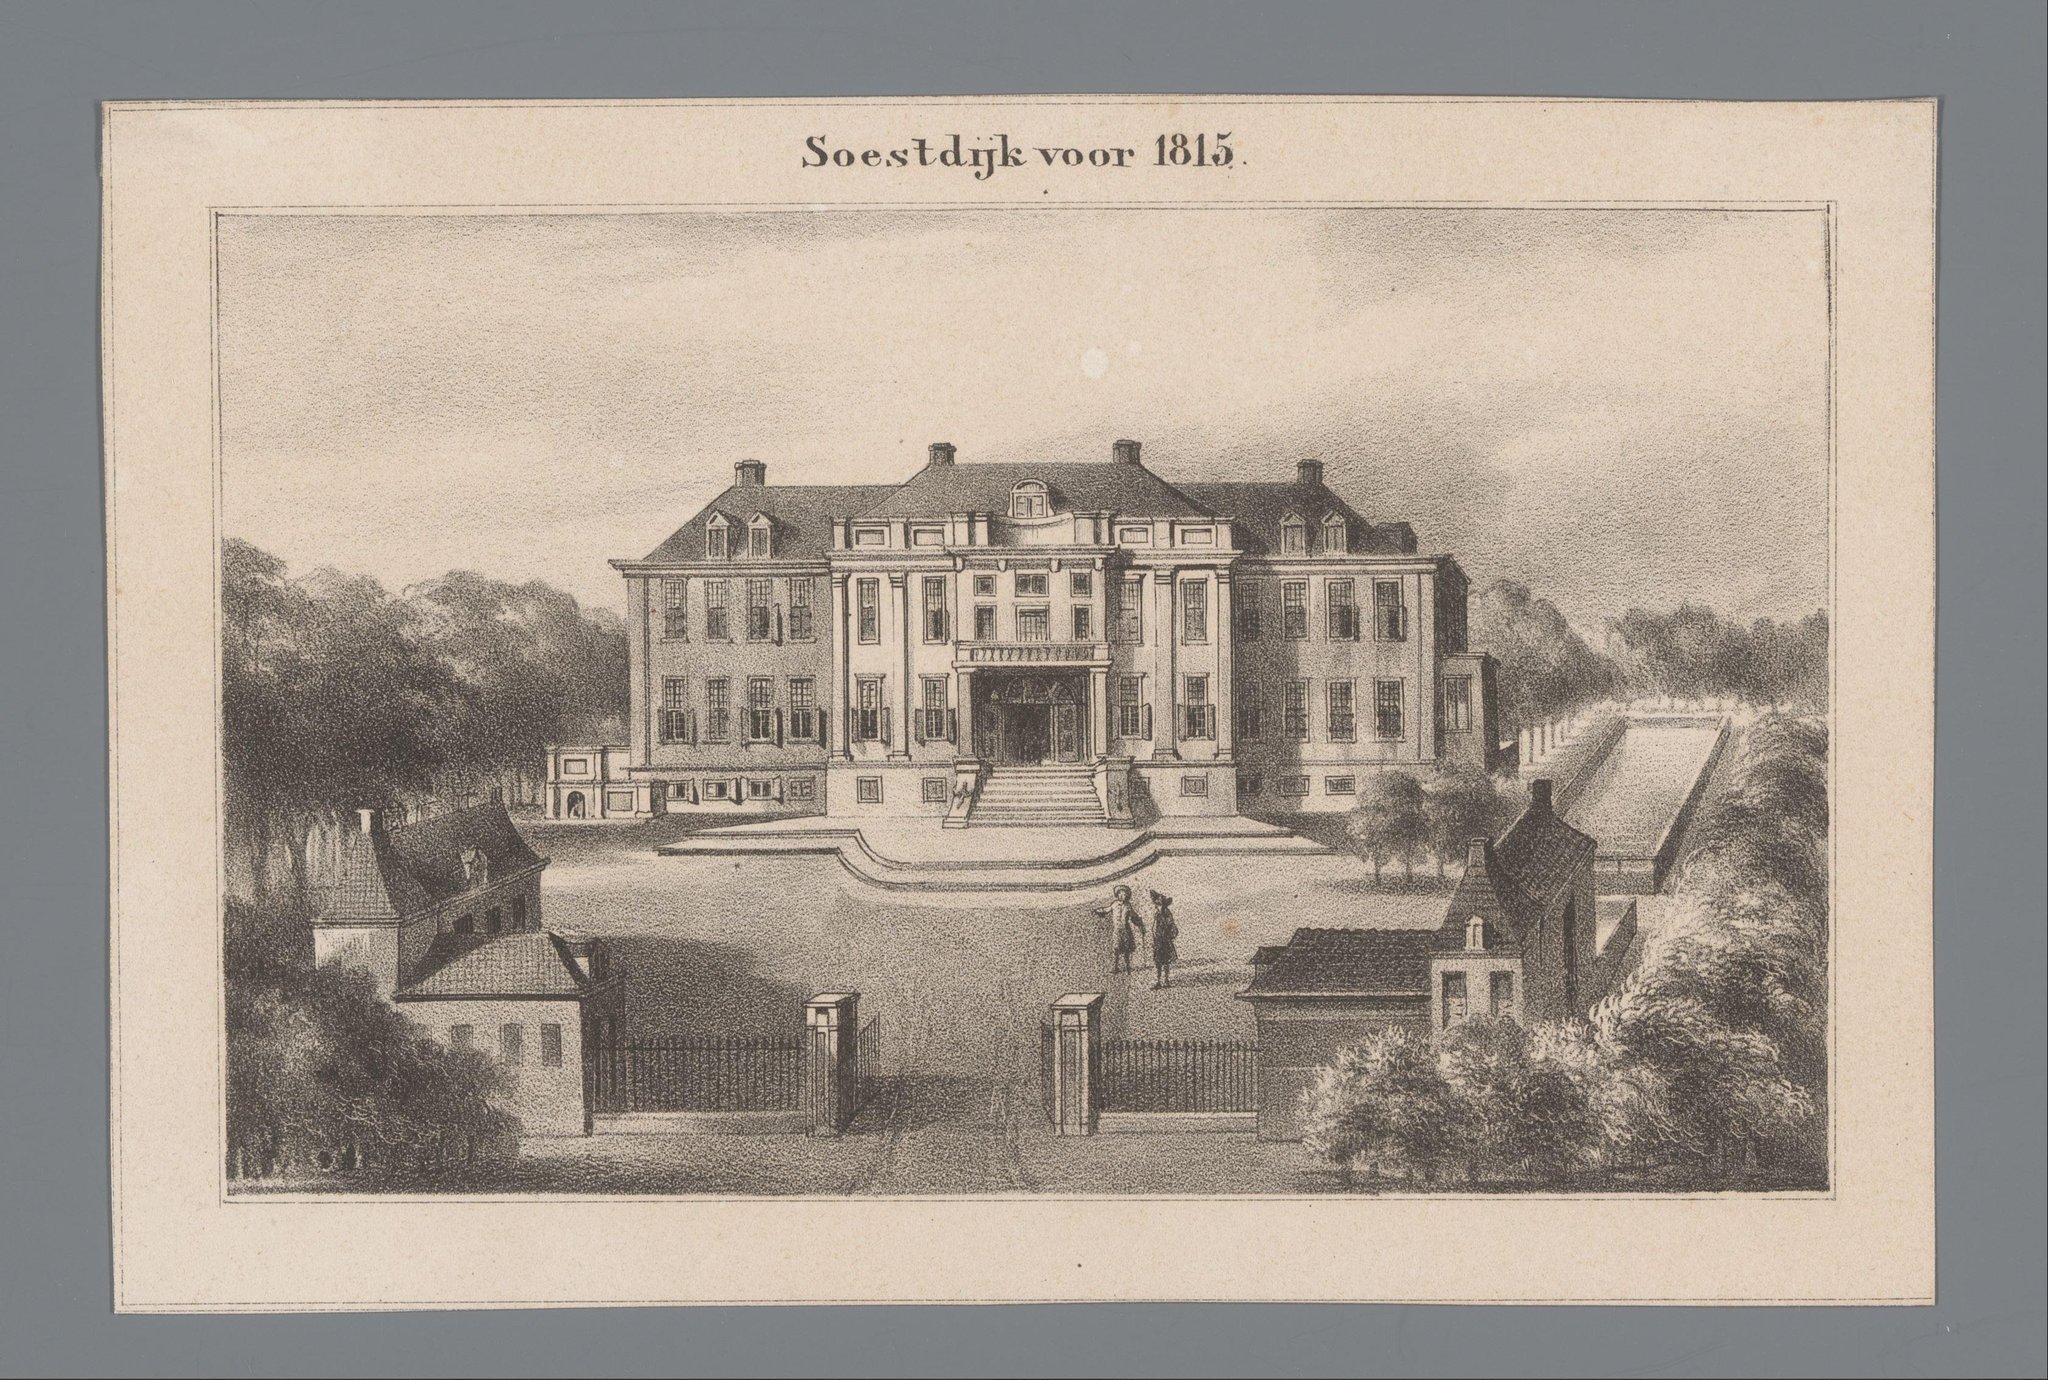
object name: print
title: Gezicht op Paleis Soestdijk, in de situatie van voor 1815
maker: Anonymous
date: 1815-1900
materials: paper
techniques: lithograph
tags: castle